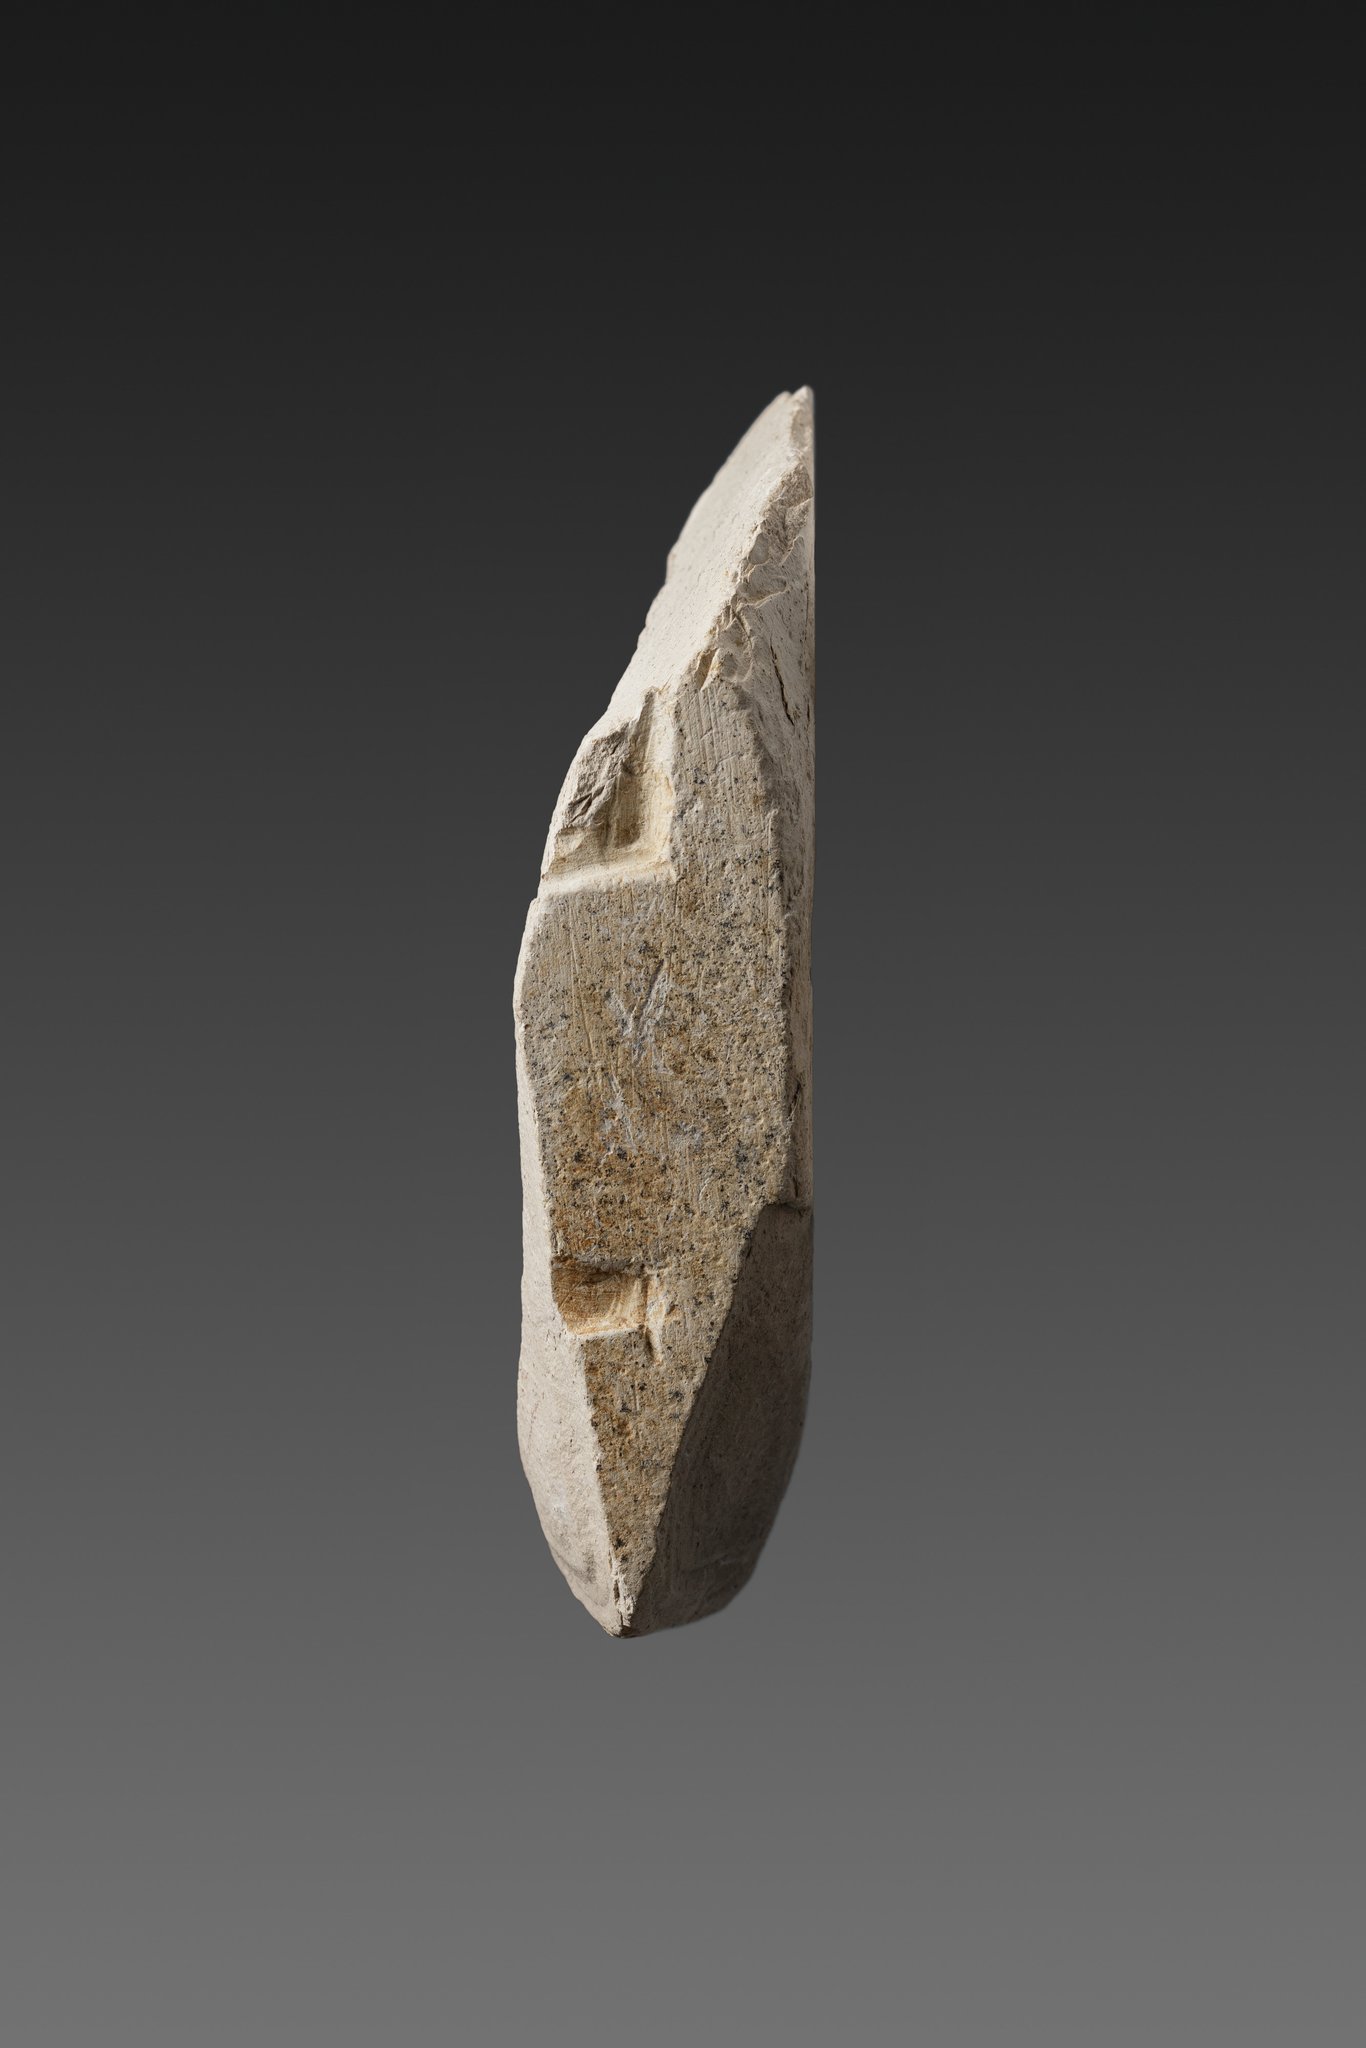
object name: relief fragment 47, tomb of mereri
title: Relief fragment possibly from the tomb of Mereri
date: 2100-2090 BCE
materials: stone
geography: egypt